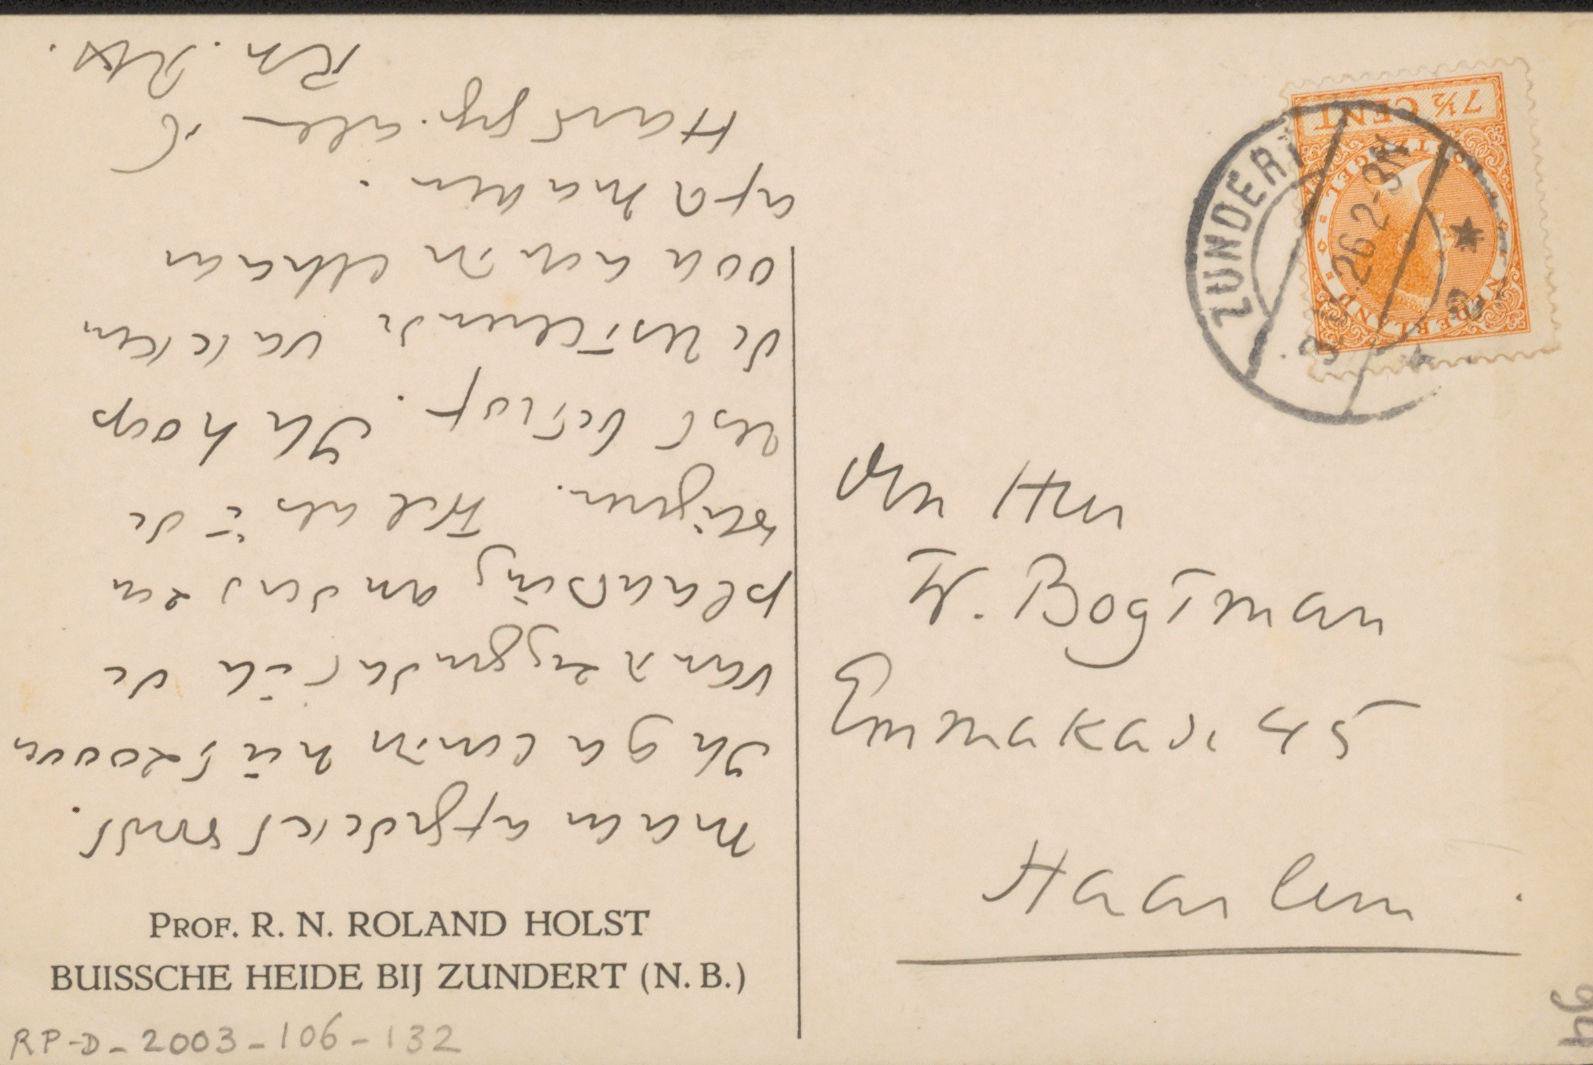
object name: postcard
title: Briefkaart aan Willem Bogtman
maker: richard nicolaüs roland holst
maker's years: 1868-1938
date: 1926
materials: cardboard, ink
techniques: pen, writing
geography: zundert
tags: haarlem, willem bogtman, applied arts, arts and crafts; industrial design